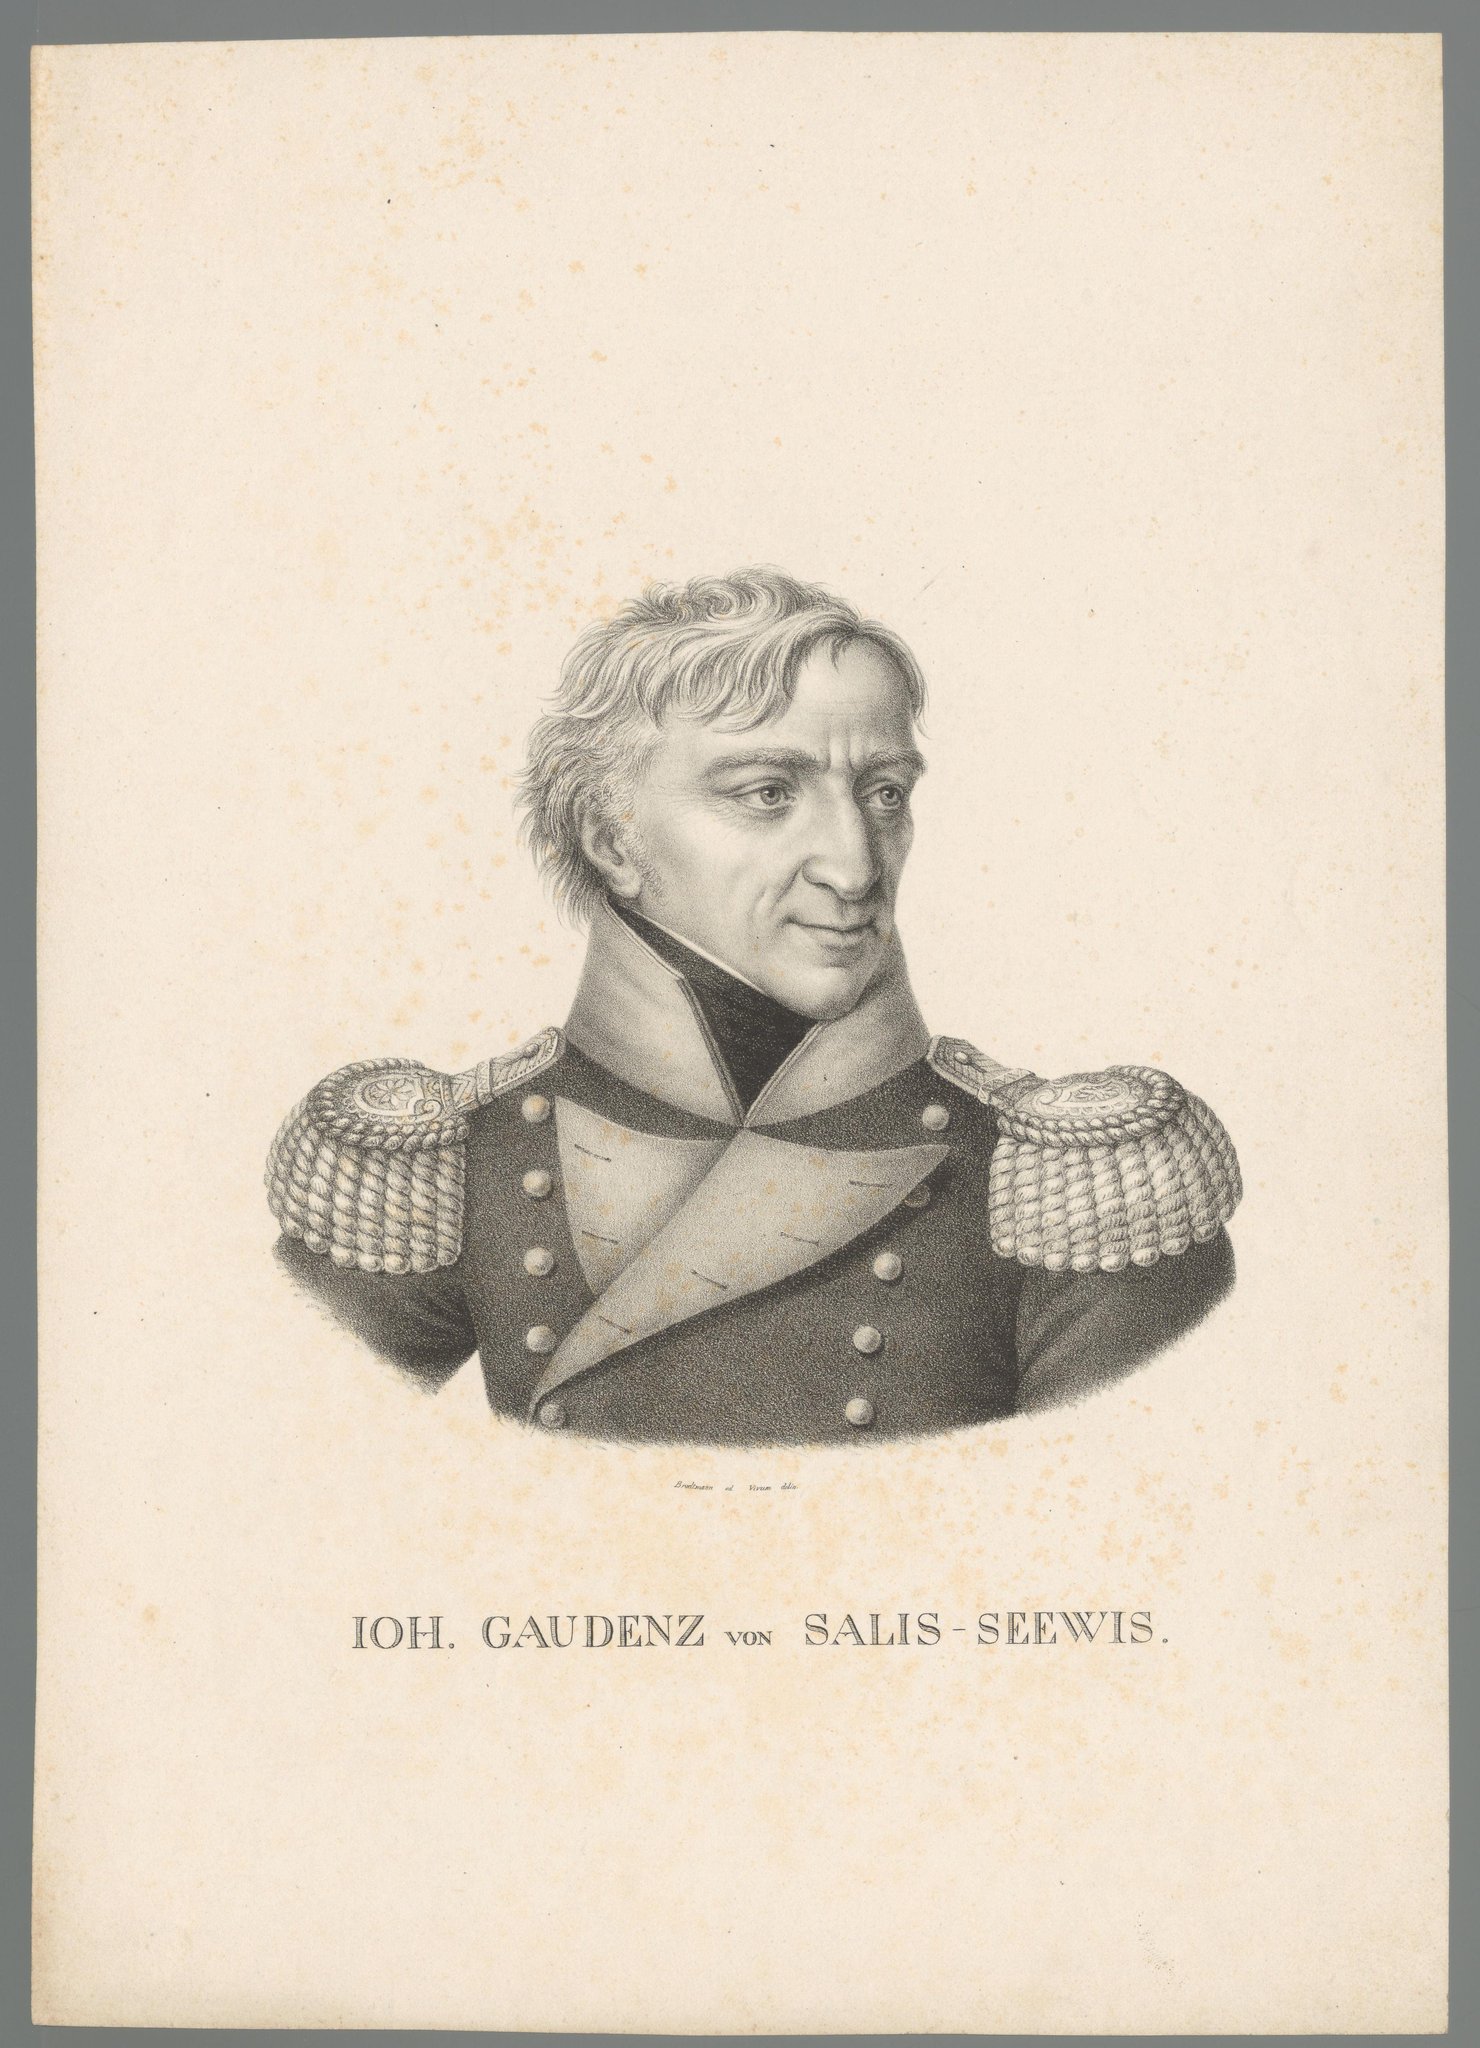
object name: print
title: Joh. Gaudenz von Salis-Seewis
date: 1797-1862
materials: paper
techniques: lithograph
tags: adult man, historical persons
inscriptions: collector's mark: Lugt 2228